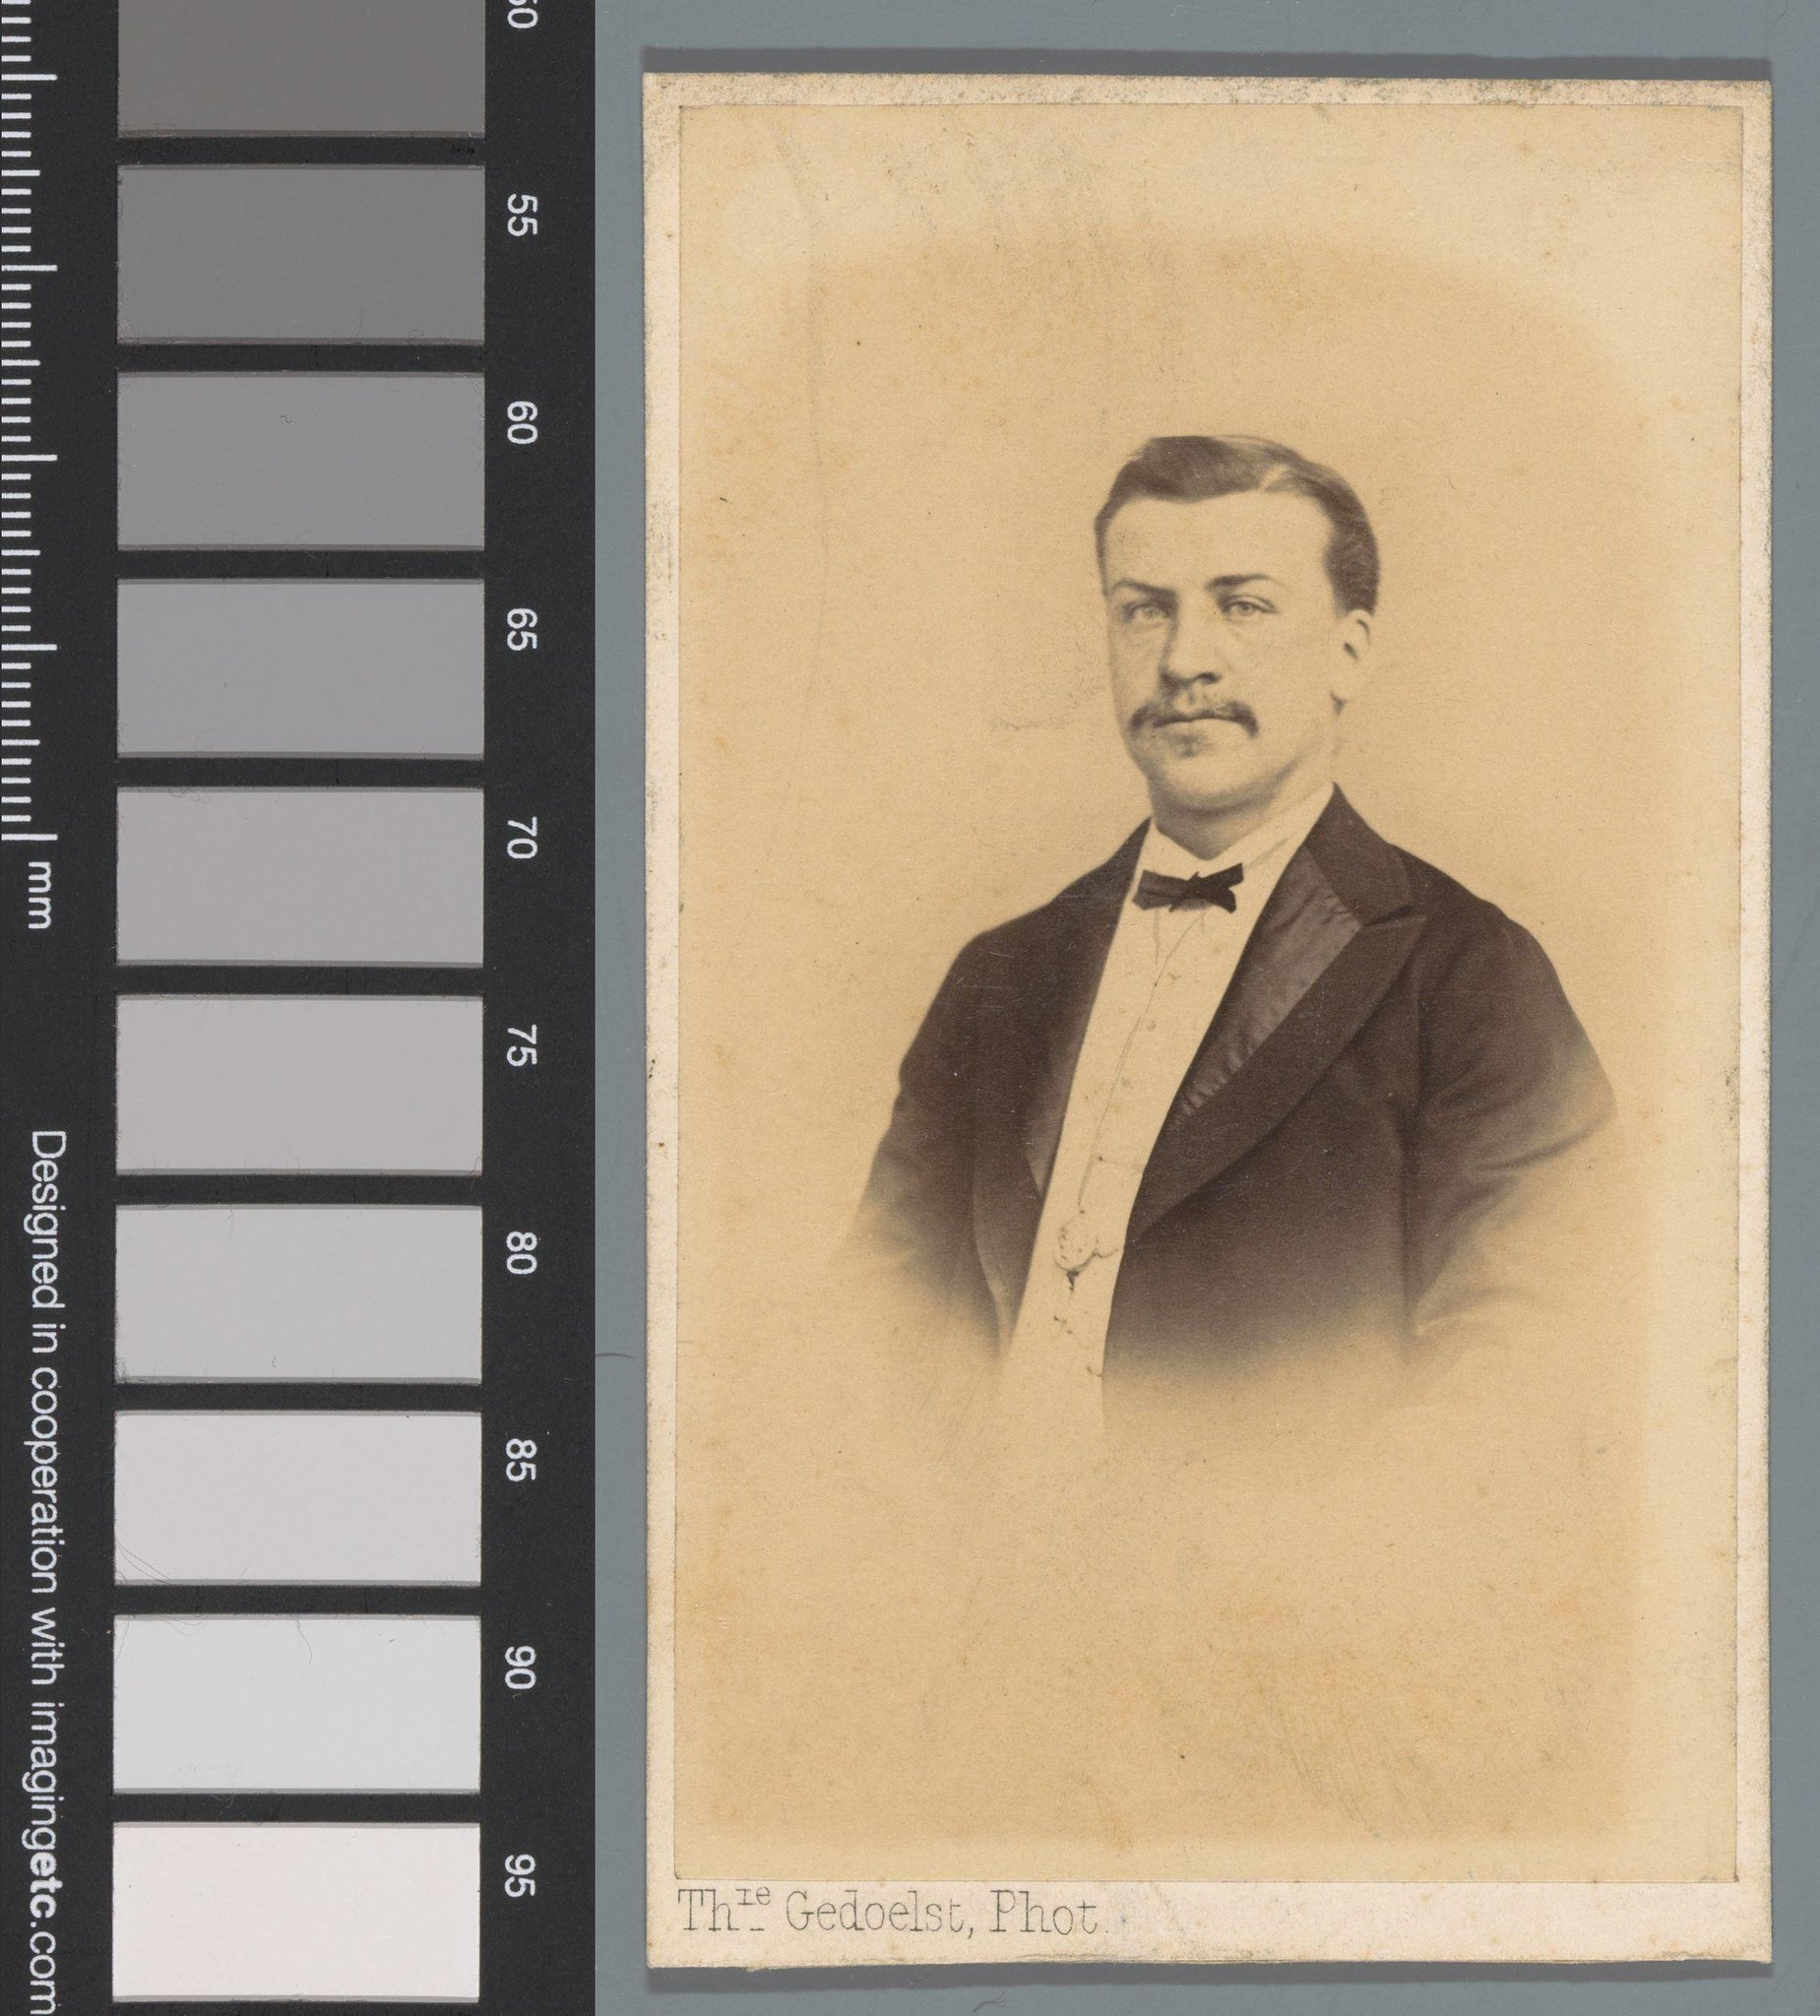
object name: photograph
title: Portret van een onbekende man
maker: théodore gedoelst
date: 1866-1883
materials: cardboard, paper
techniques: albumen print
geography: leuven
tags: adult man, anonymous historical person portrayed, louvain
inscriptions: inscription: ‘Atlier de Photographie./ Thre Gedoelst,/ Rue de Namur, 99./ Louvain’, inscription: ‘Thre Gedoelst, Phot.’